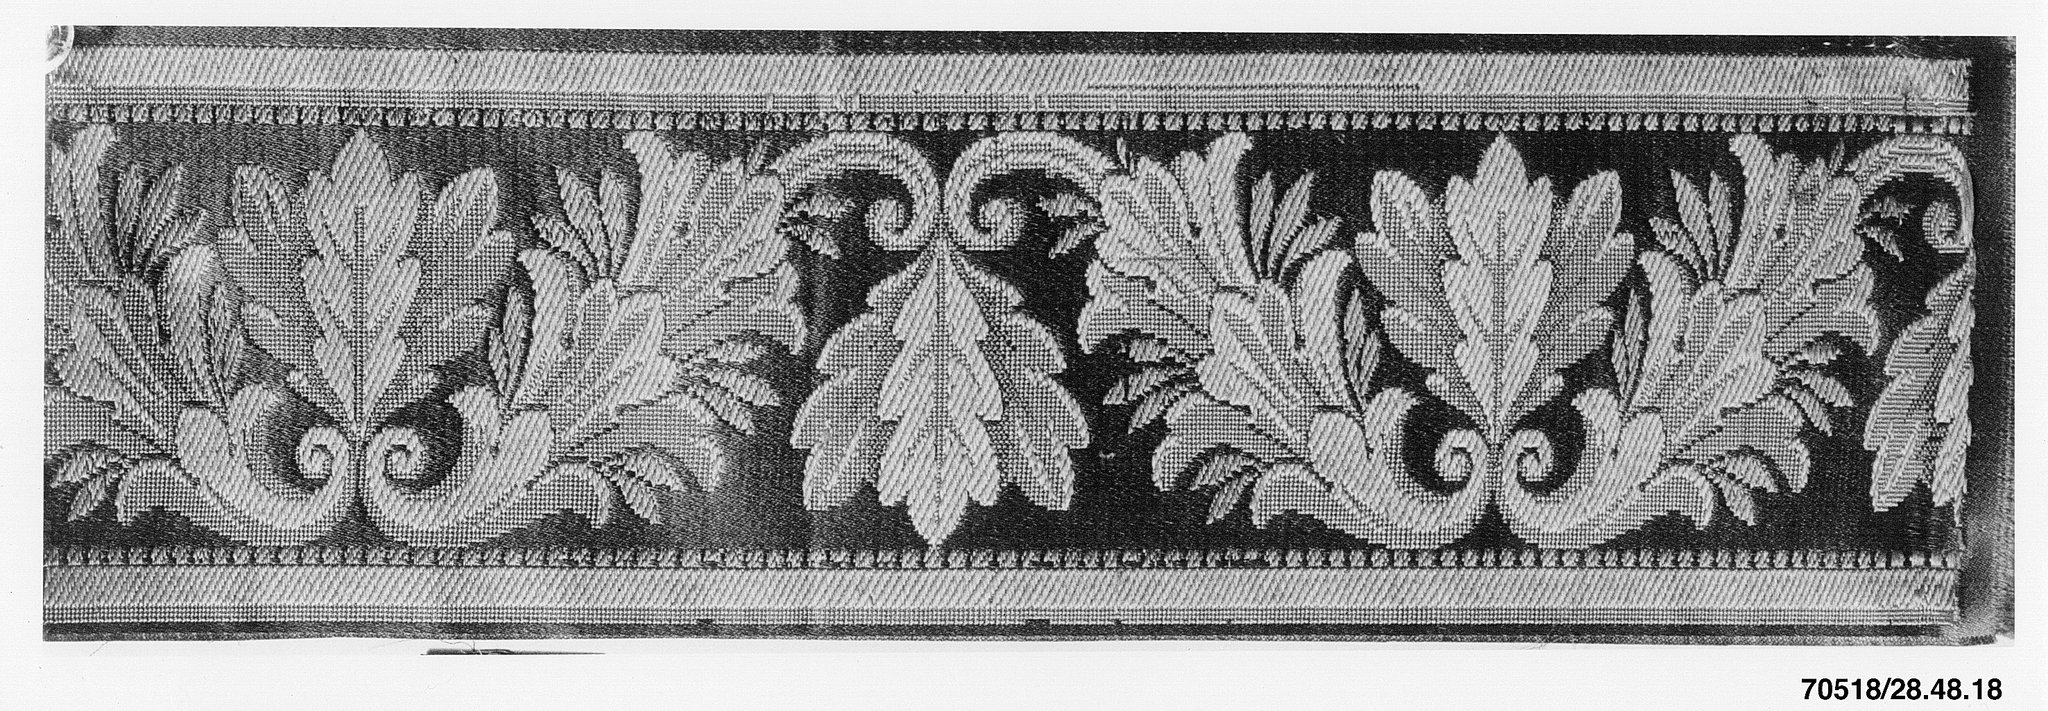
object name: border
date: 1801-1900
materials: silk